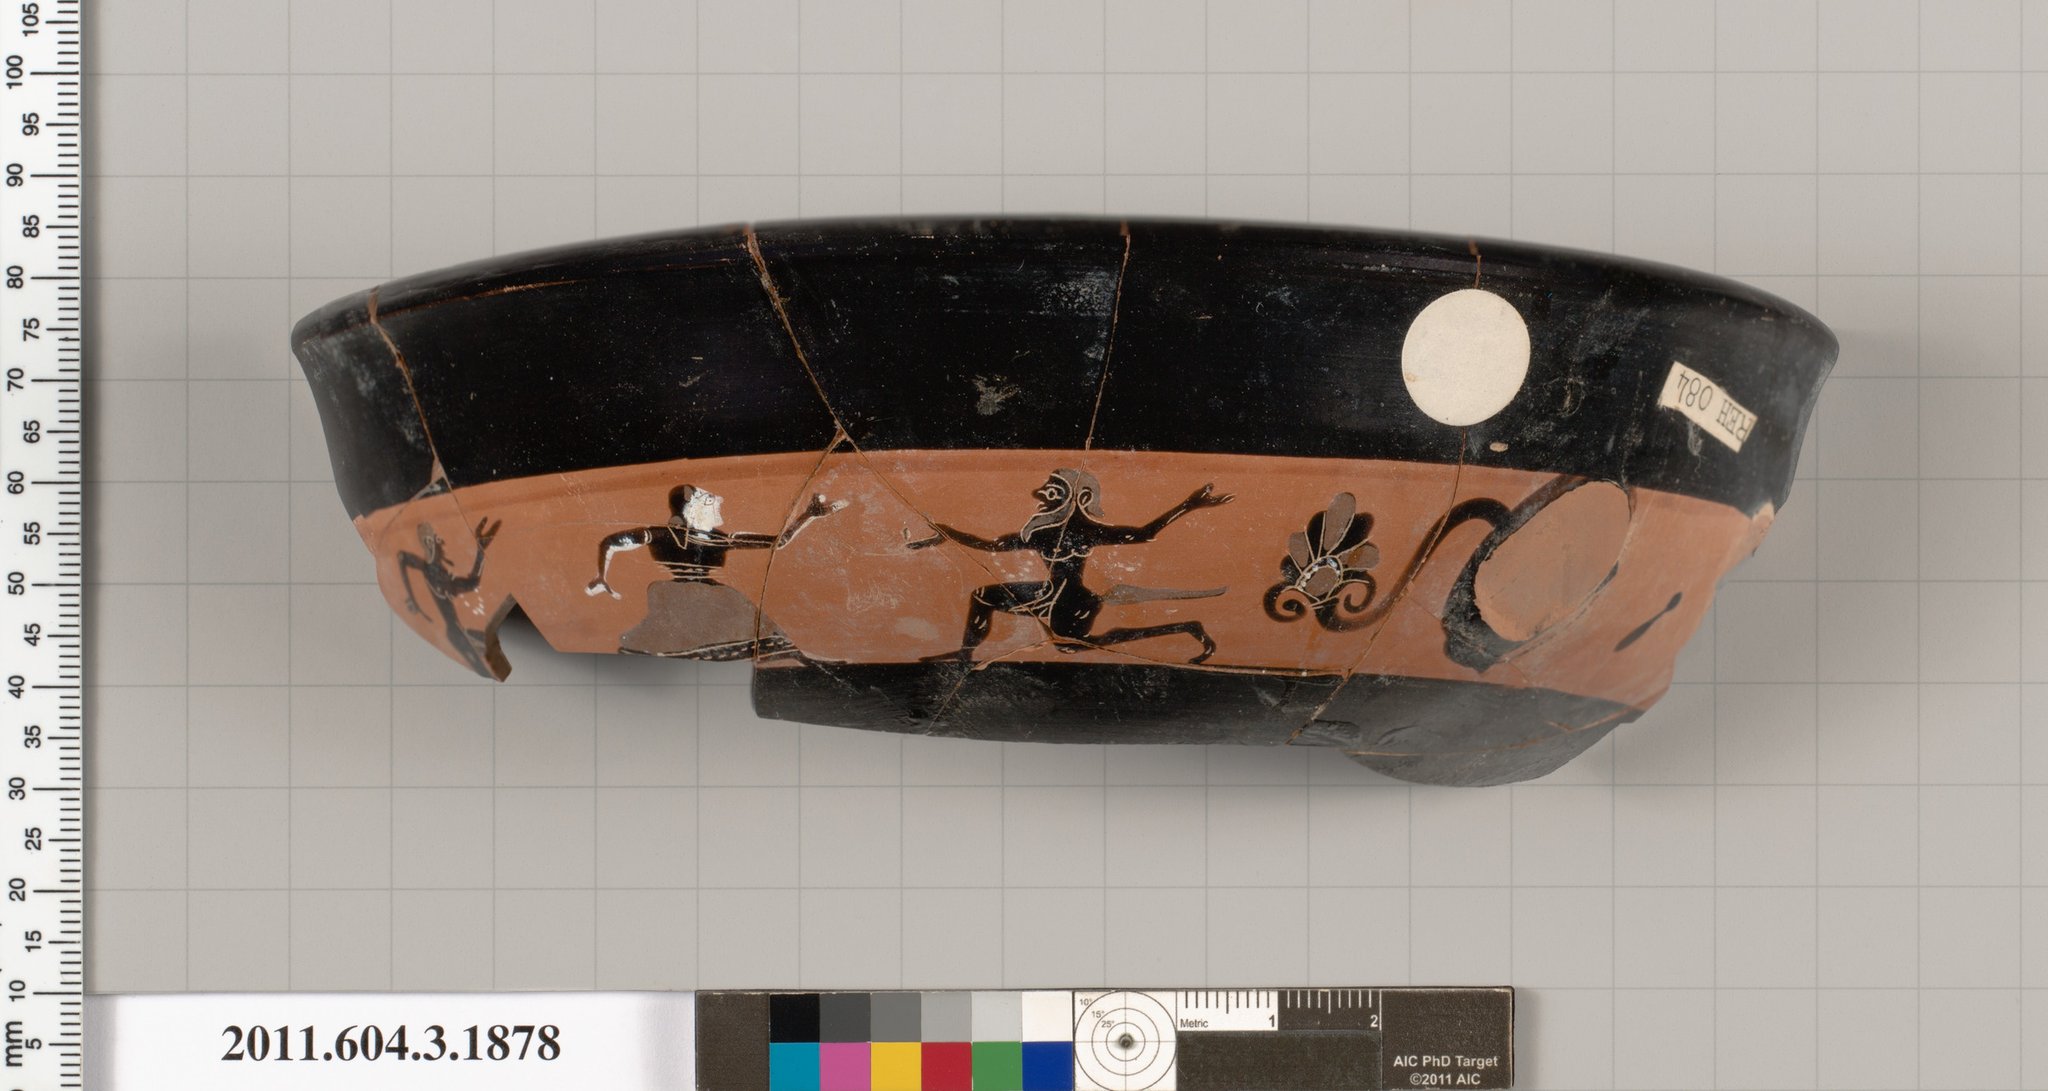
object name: kylix fragment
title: Terracotta fragment of a kylix: Band cup (drinking cup)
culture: greek, attic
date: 560-550 BCE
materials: terracotta